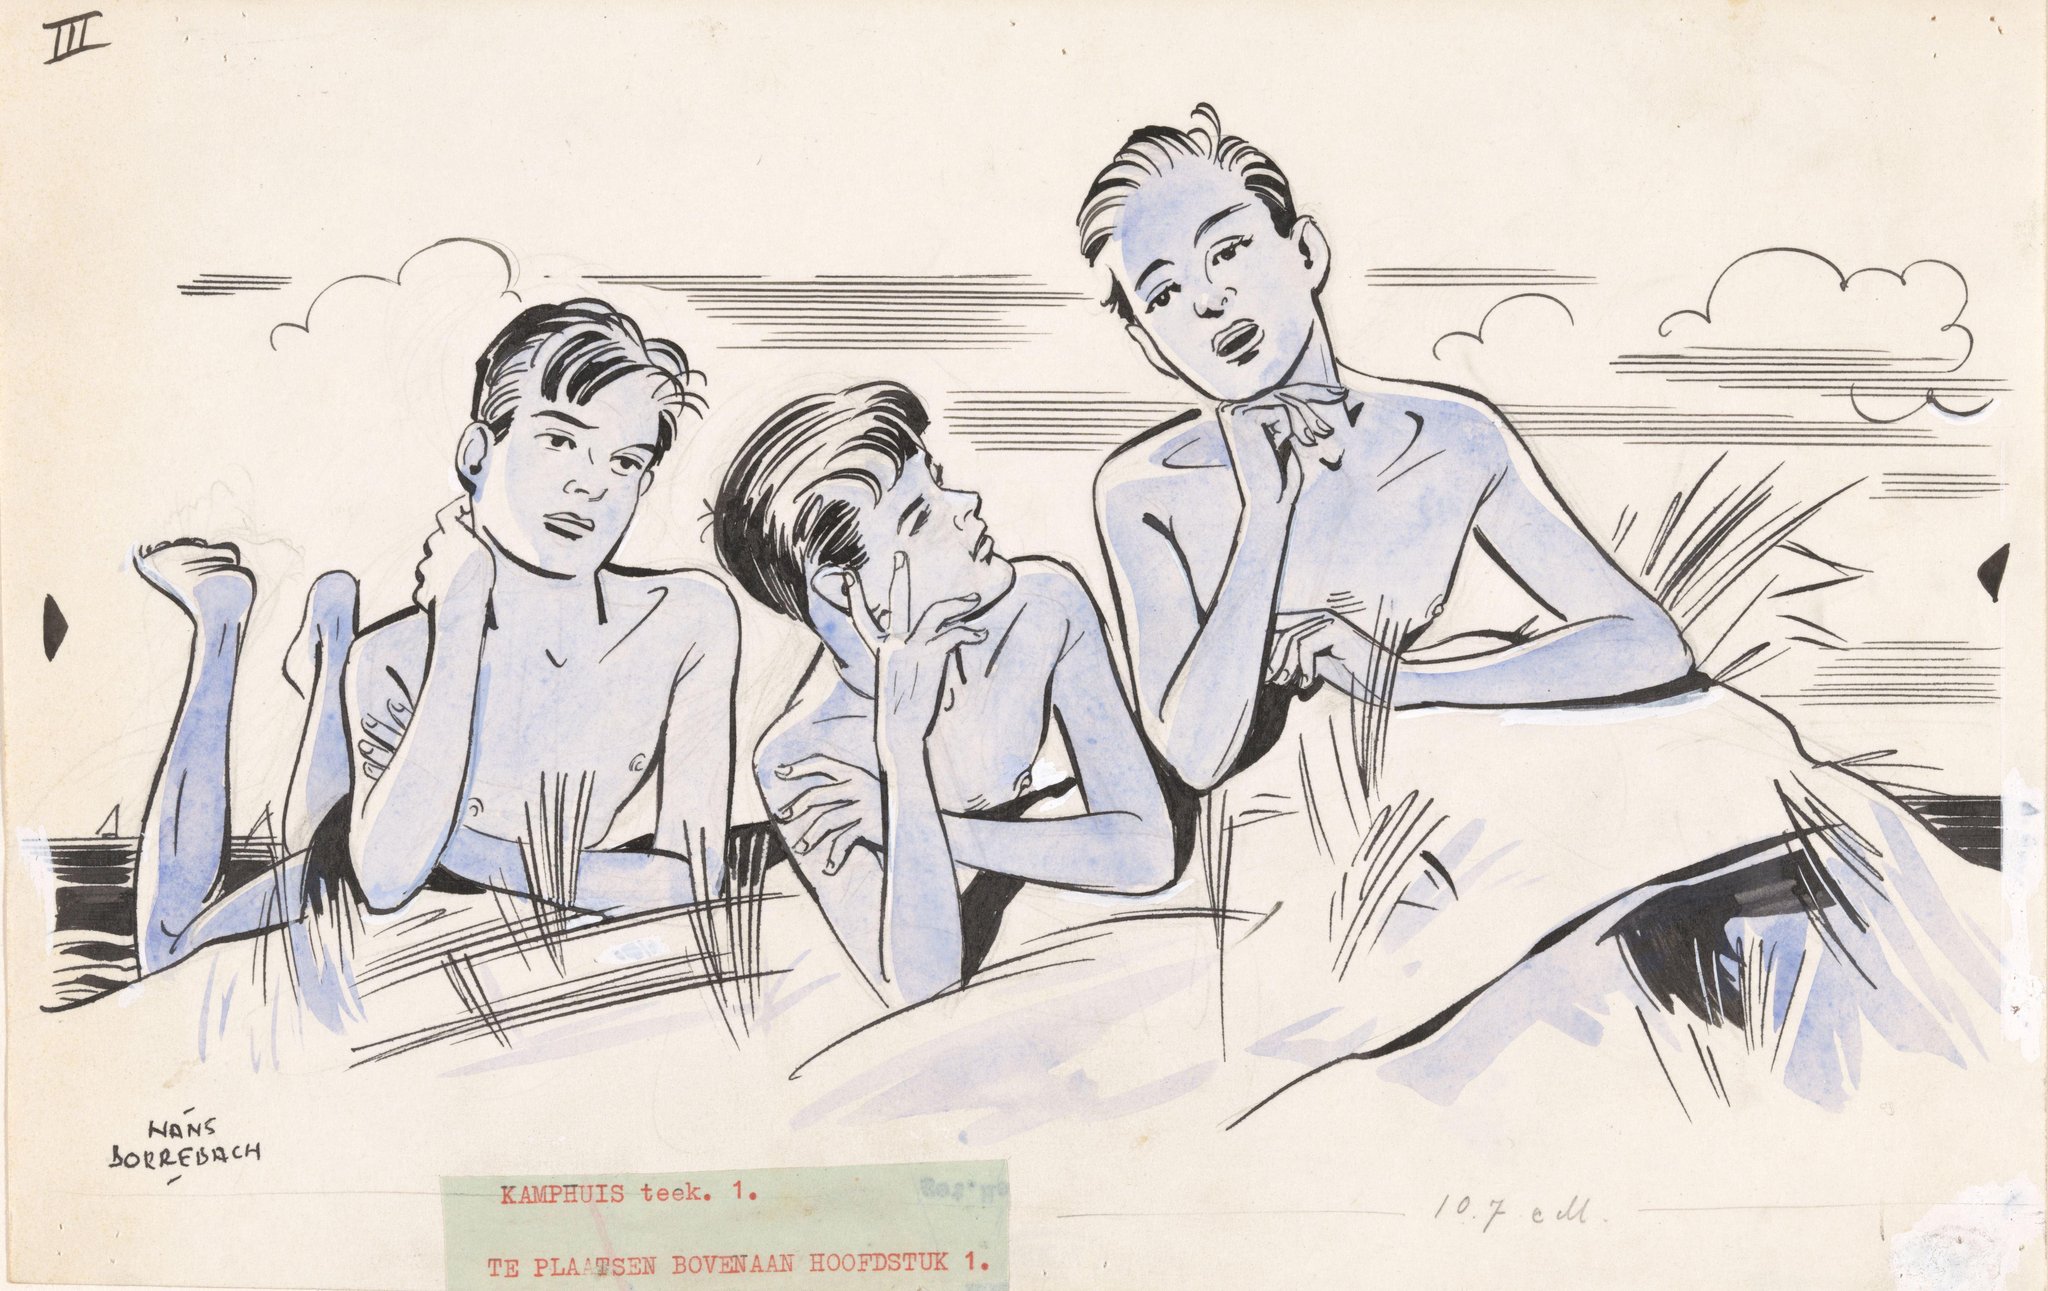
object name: drawing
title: Drie jongens liggend op het duin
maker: hans borrebach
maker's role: draughtsman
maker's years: 1903-1991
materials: paint, ink, paper, pencil, watercolor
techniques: brush, pen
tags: recreation in the dunes, boy (child between toddler and youth), sea (seascape)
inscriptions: number: ‘III’, :, annotation: ‘KAMPHUIS teek. 1/ TE PLAATSEN BOVENAAN HOOFDSTUK 1.’, collector's mark: Lugt 2228a, signature: ‘HANS/ BORREBACH’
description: Drie jongen in zwembroek liggen naast elkaar op hun buik op het duin. Ze ondersteunen hun hoofd met hun handen. Op de achtergrond is de zee te zien.